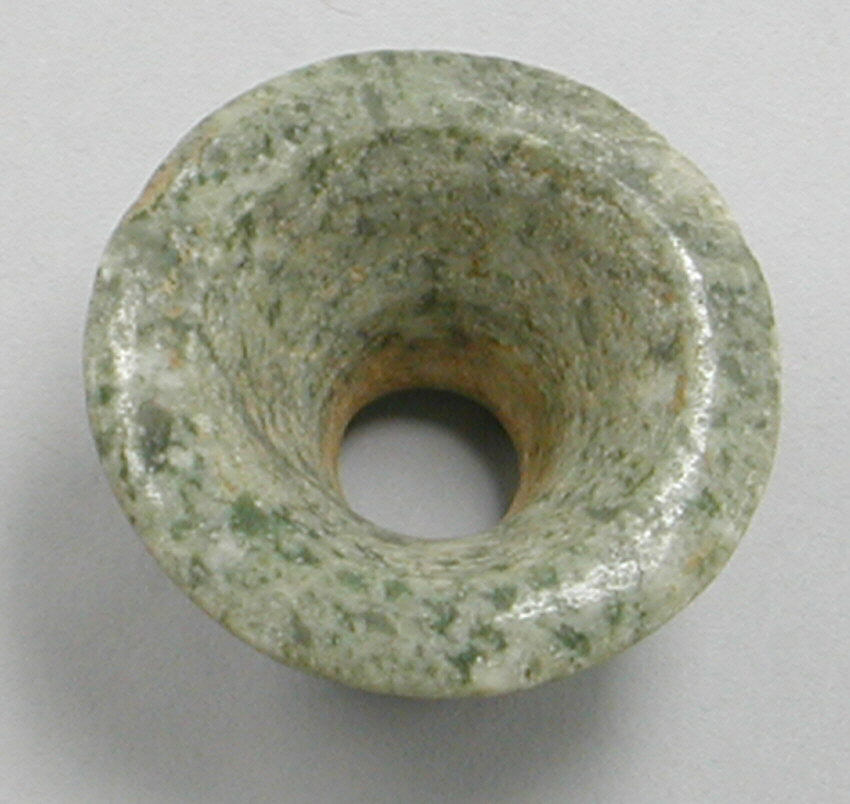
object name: earflare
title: Stone Earflare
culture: mexican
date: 1501-1600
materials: stone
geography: mexico